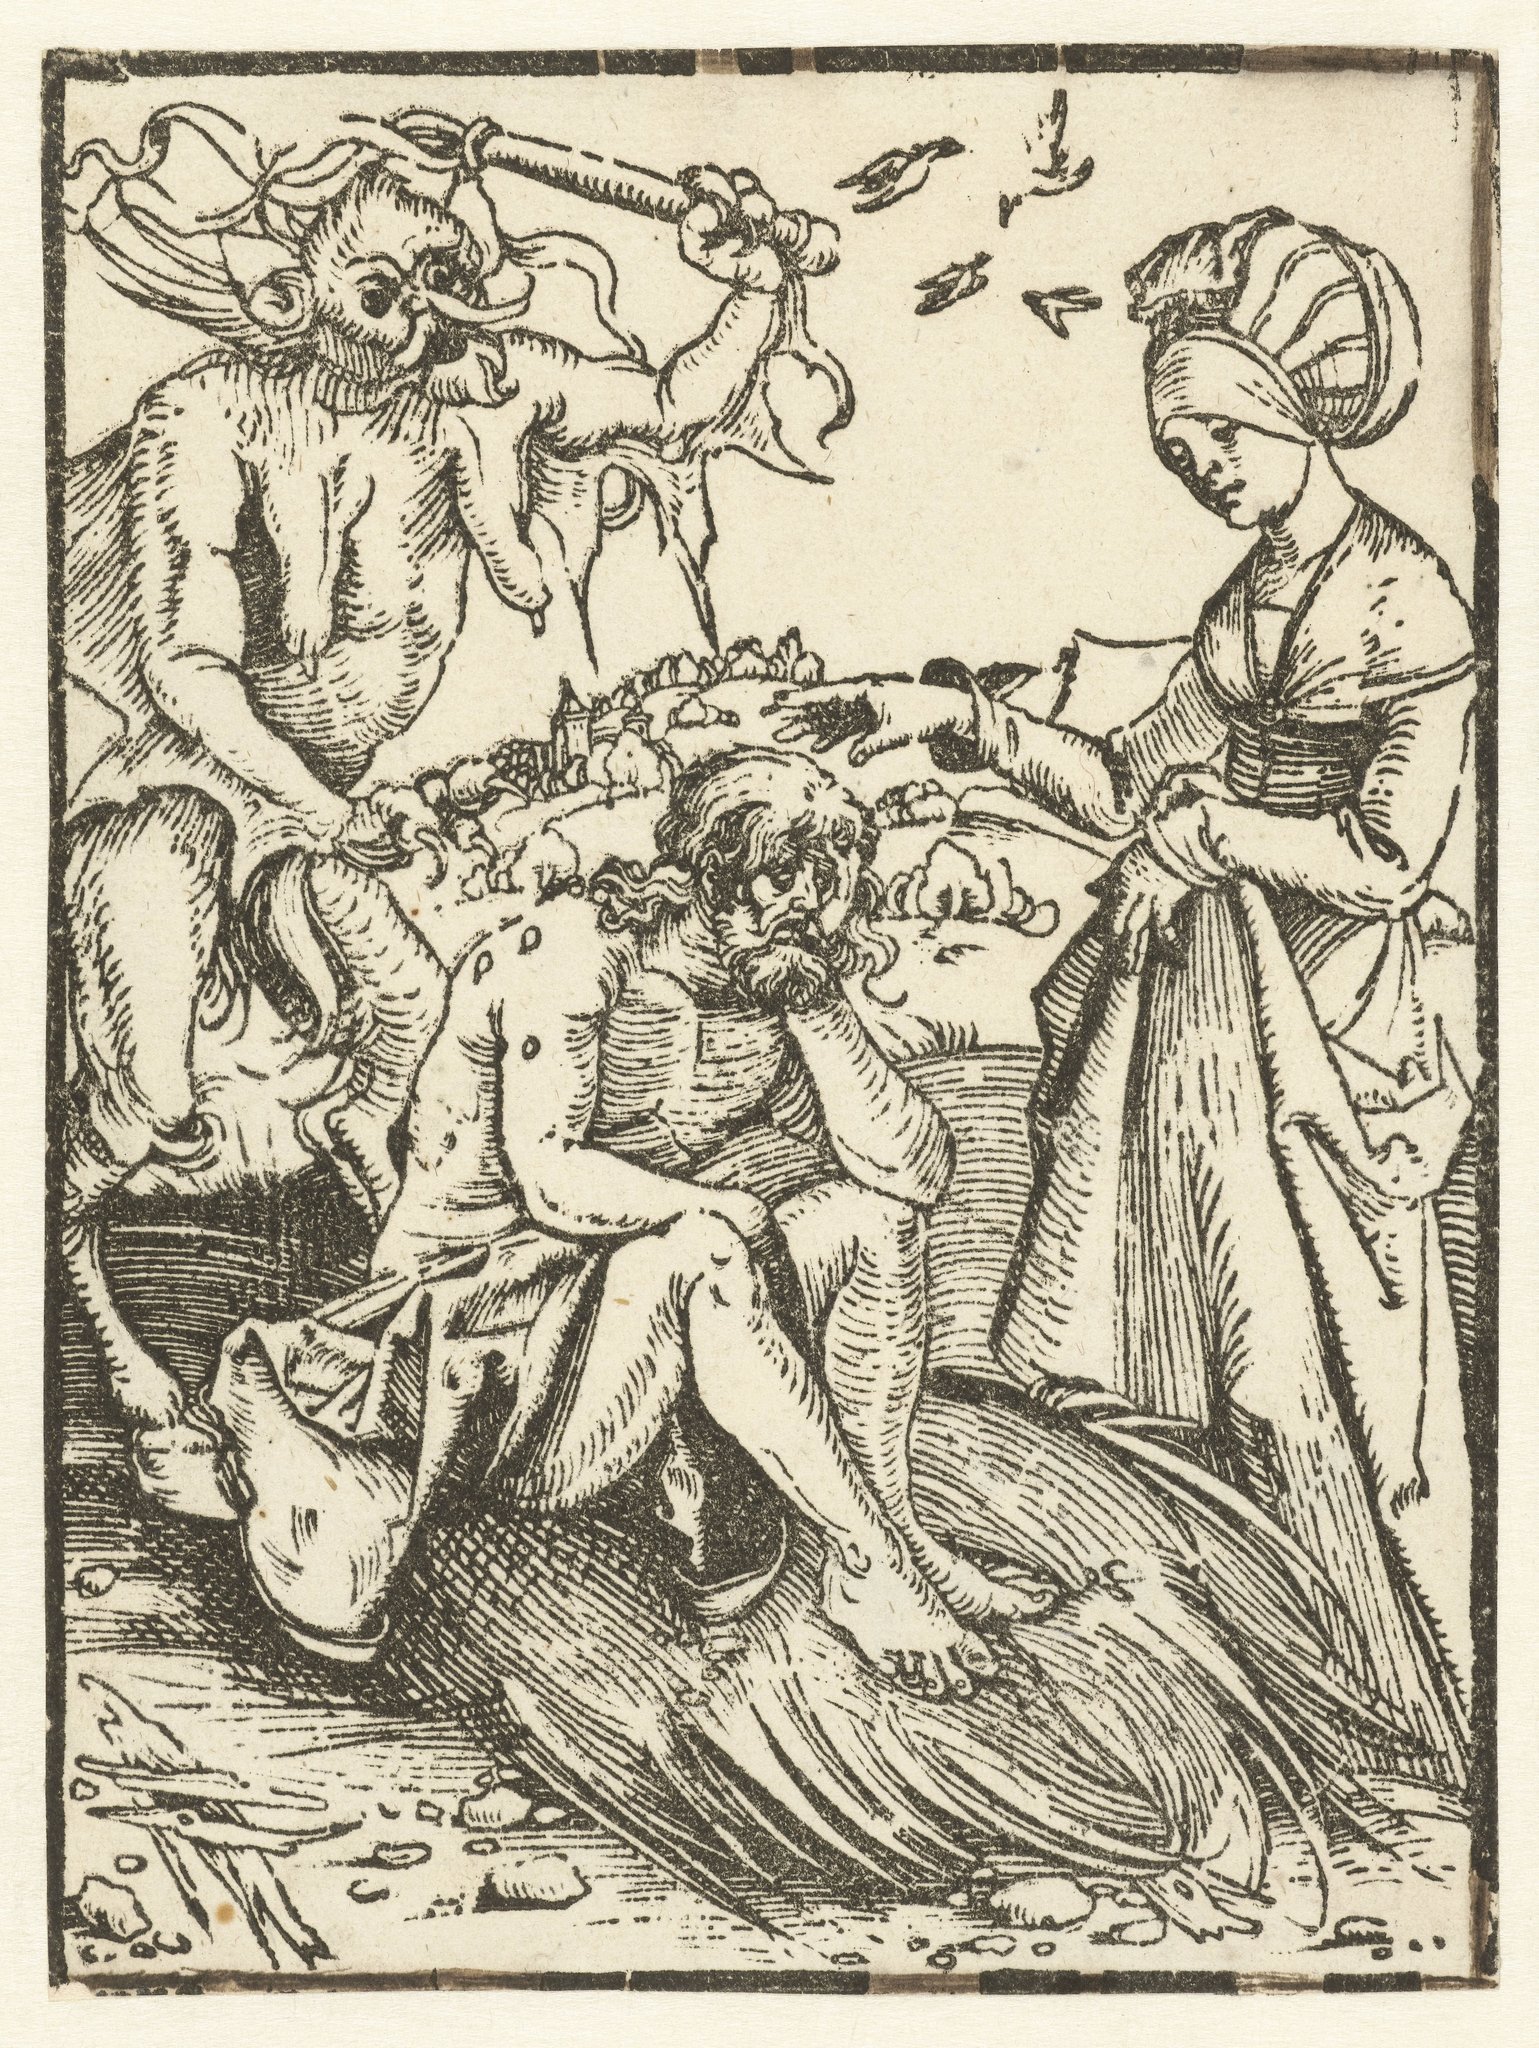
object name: print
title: Job op de mestvaalt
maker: albrecht dürer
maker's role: draughtsman, painter, print maker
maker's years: 1471-1528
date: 1509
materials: paper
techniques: woodcut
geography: nuremberg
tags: job on the dunghill with satan (or devils) abusing and tormenting him; job's wife may be present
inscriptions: collector's mark: Lugt 240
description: Illustratie voor: Ulrich Pinder, Speculum patientie, Neurenberg 1509. Dit exemplaar echter als losse prent uitgegeven. Klinkert, C.